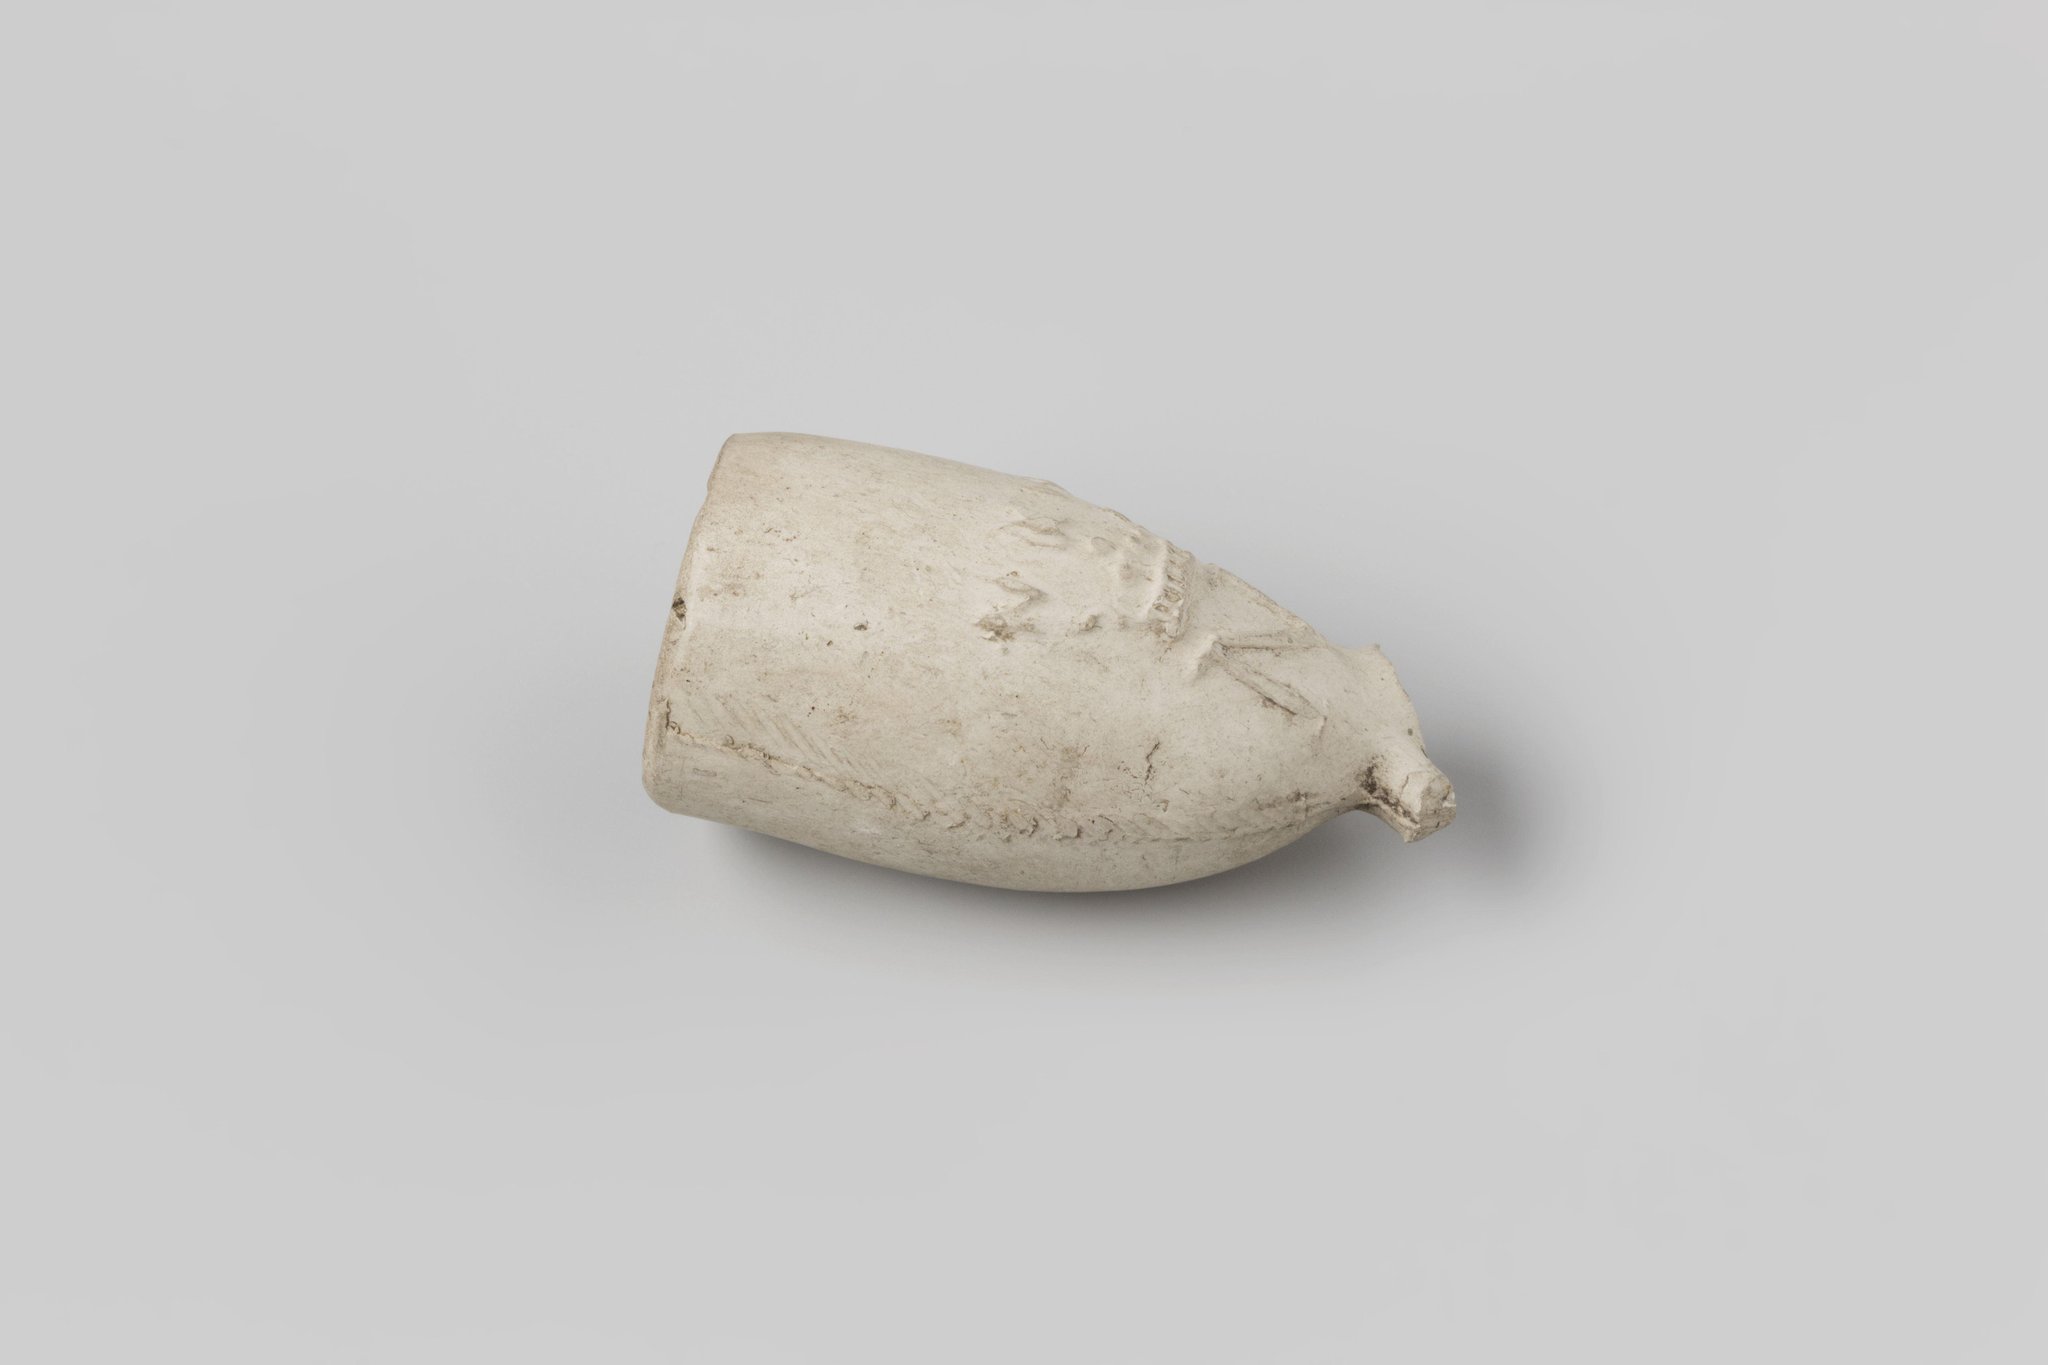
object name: pipe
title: Fragment pijpenkop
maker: nicolaas walter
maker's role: pijpenfabrikant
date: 1790-1794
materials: clay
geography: schoonhoven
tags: the hague, rotterdam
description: Fragment pijpenkop met de letters N K W en gekroonde N. Van de opgravingen op de Hofstede Arentsburg 1827-1831 onder toezicht van Professor Reuvens.